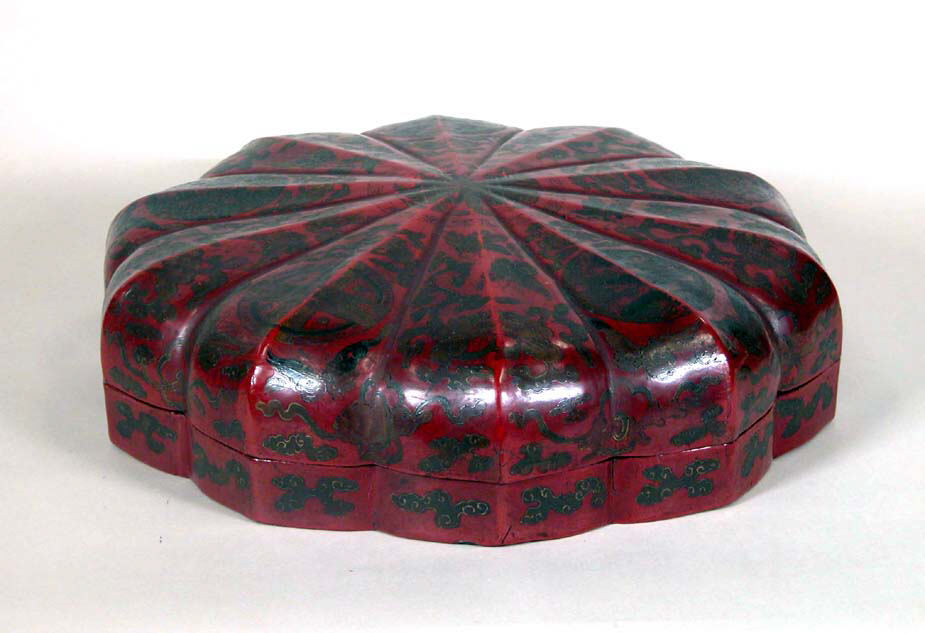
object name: covered box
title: Lobulated Covered Box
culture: japanese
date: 1601-1700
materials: gold, lacquer